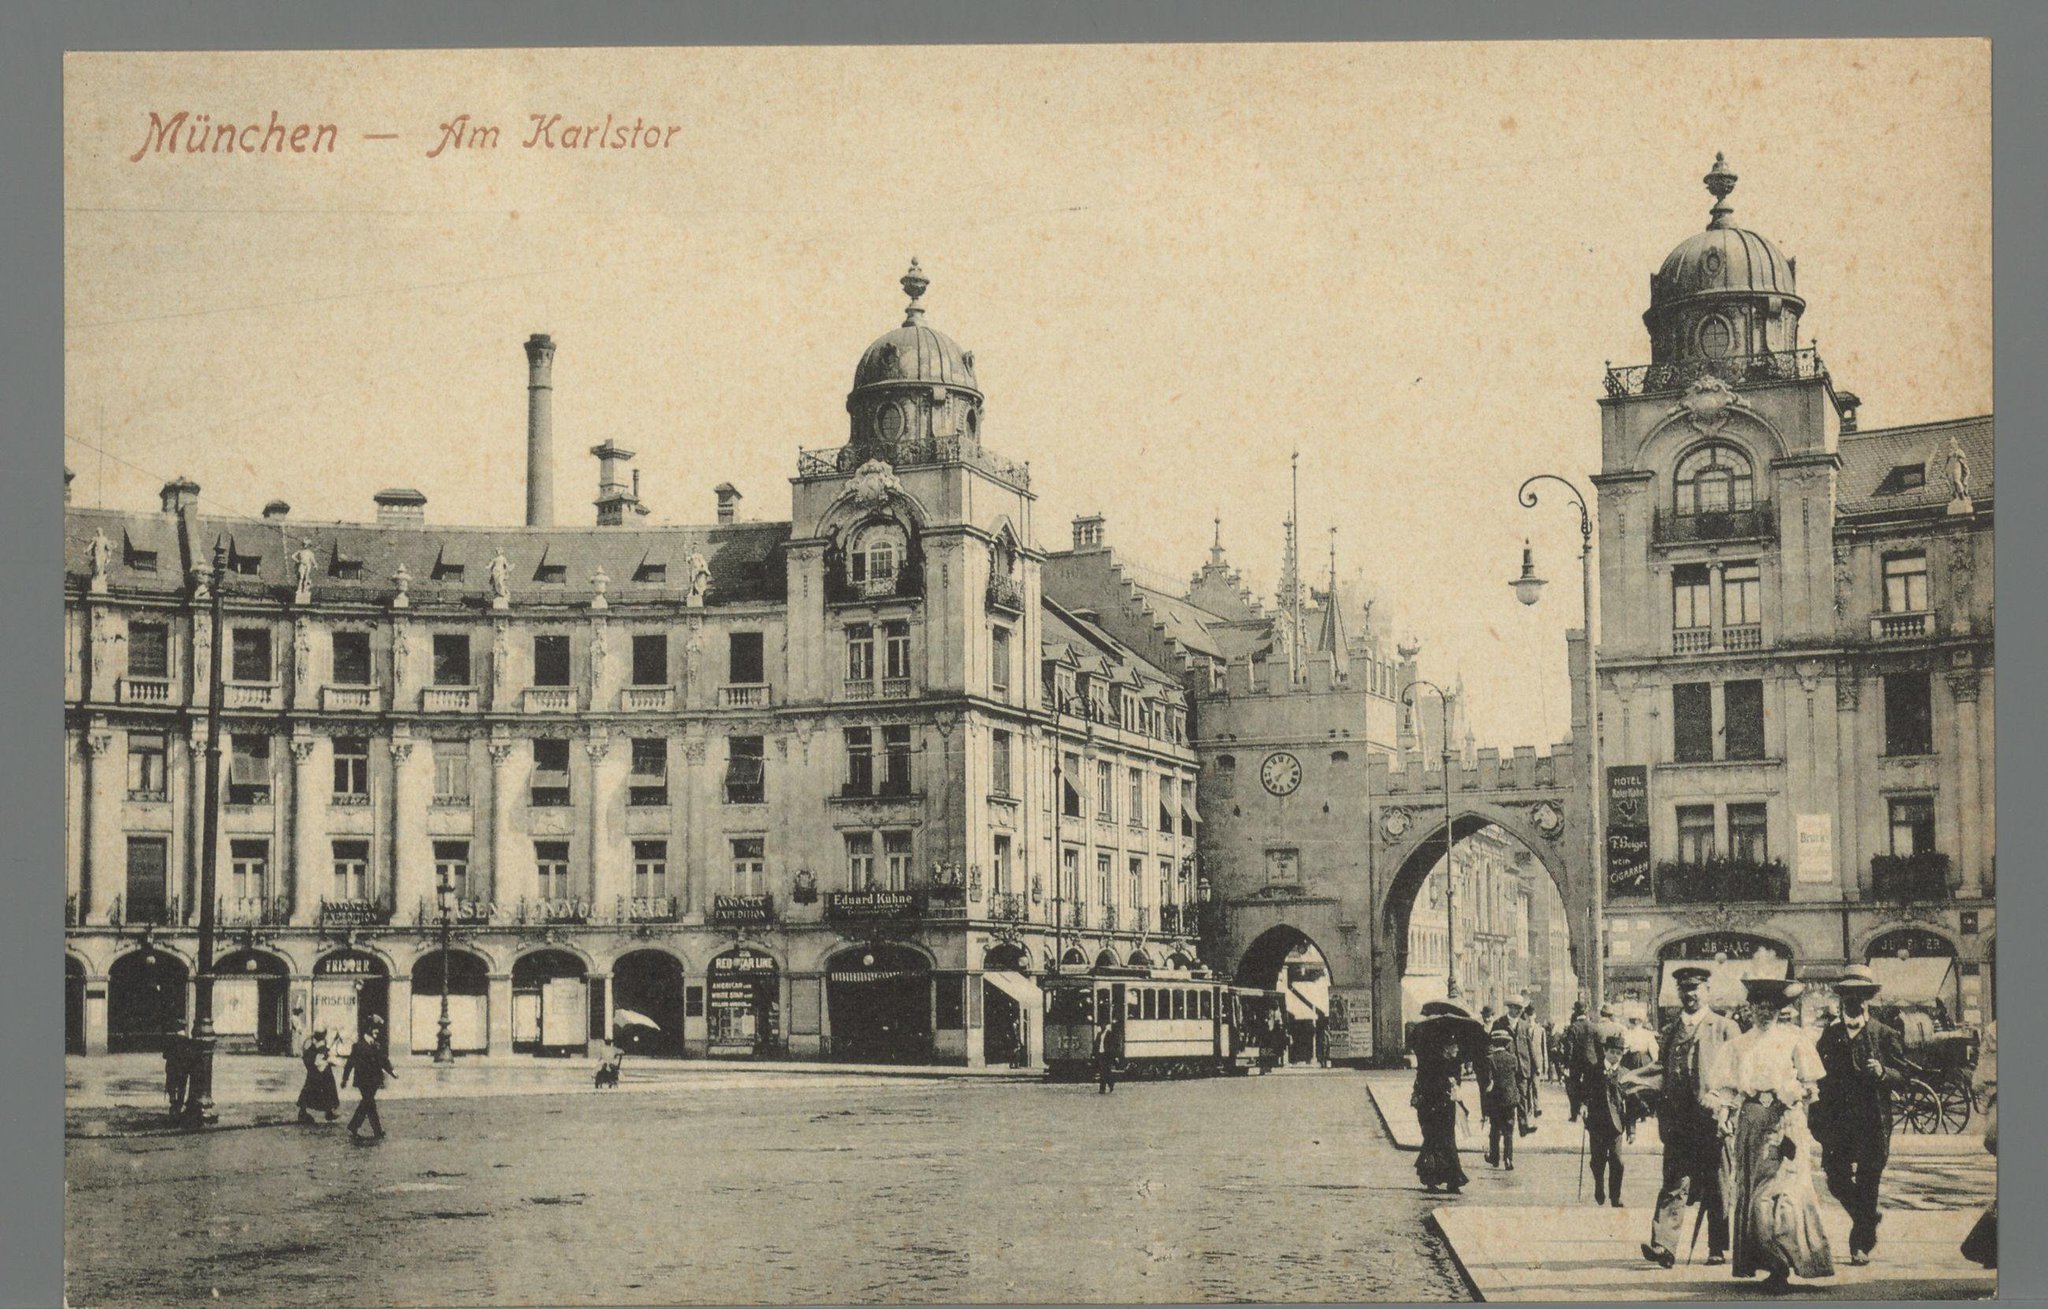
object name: ansichtkaart, prentbriefkaart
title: München - Am Karlstor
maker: Anonymous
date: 1905-1930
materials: cardboard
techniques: photograph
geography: munich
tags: square, place, circus, etc., city-gate